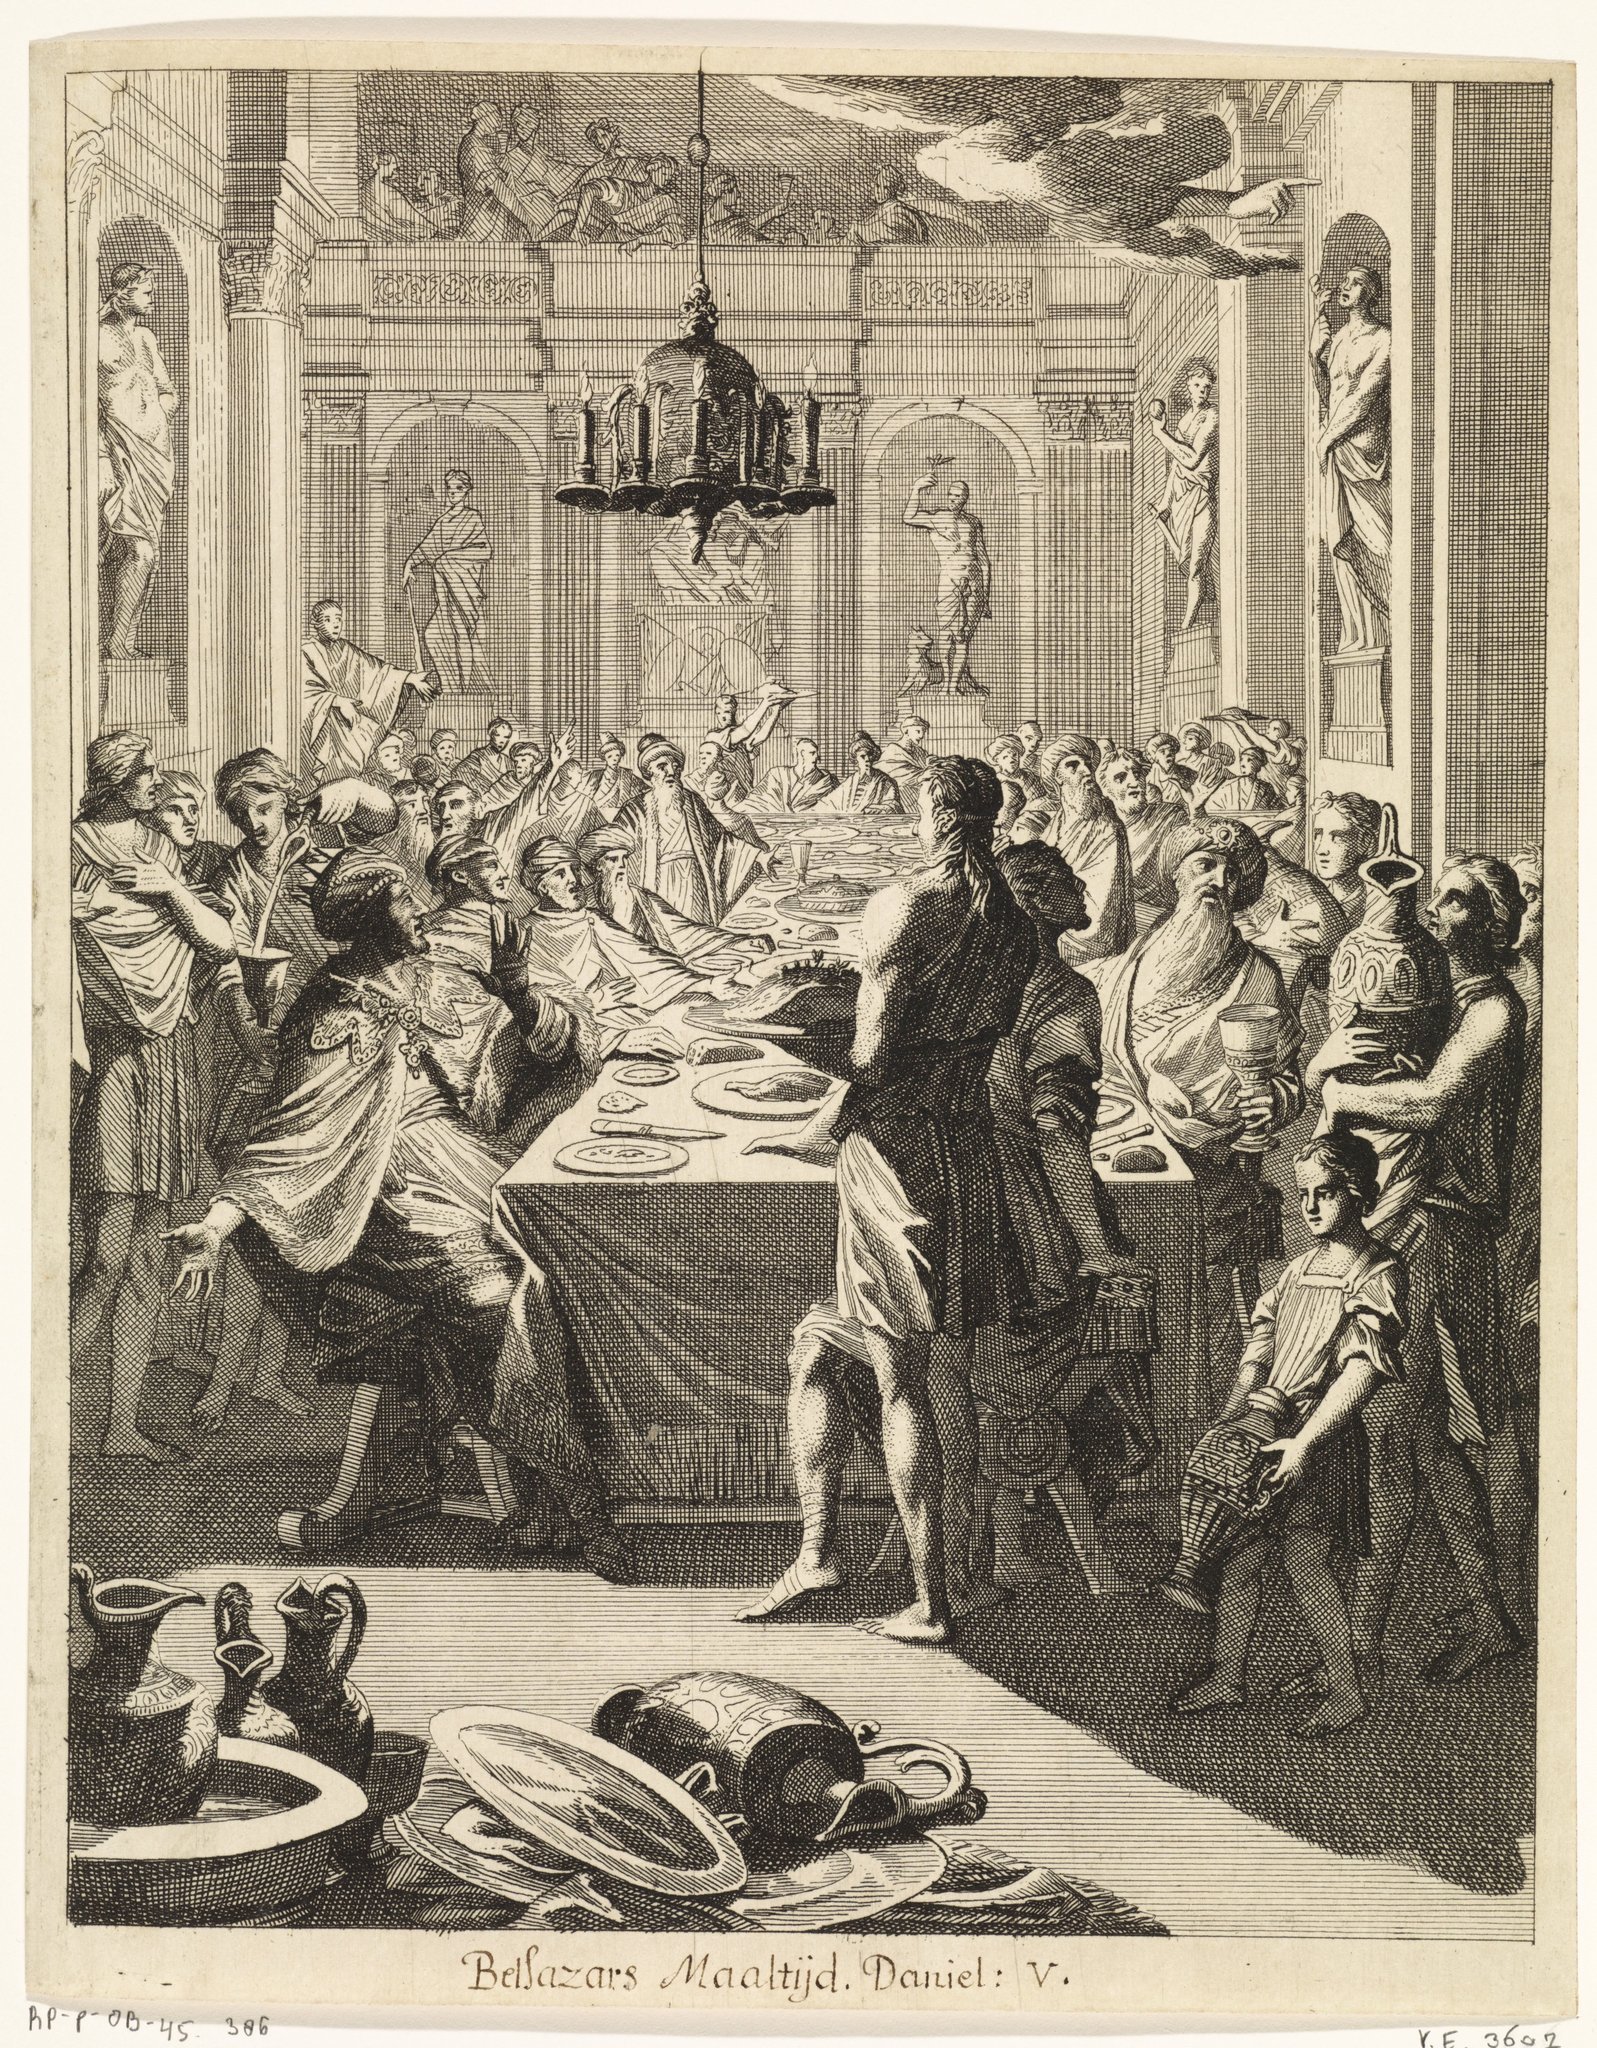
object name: print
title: Feestmaal van Belsassar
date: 1708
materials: paper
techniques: etching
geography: nuremberg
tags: during belshazzar's banquet a hand appears and writes on the wall (mene, mene, tekel and parsin (upharsin)); king belshazzar is frightened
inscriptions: collector's mark: Lugt 2228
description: Proefdruk van een prent welke is opgenomen als illustratie in: Historiae Celebriores Veteris Testamenti. Christoph Weigel, 1708.